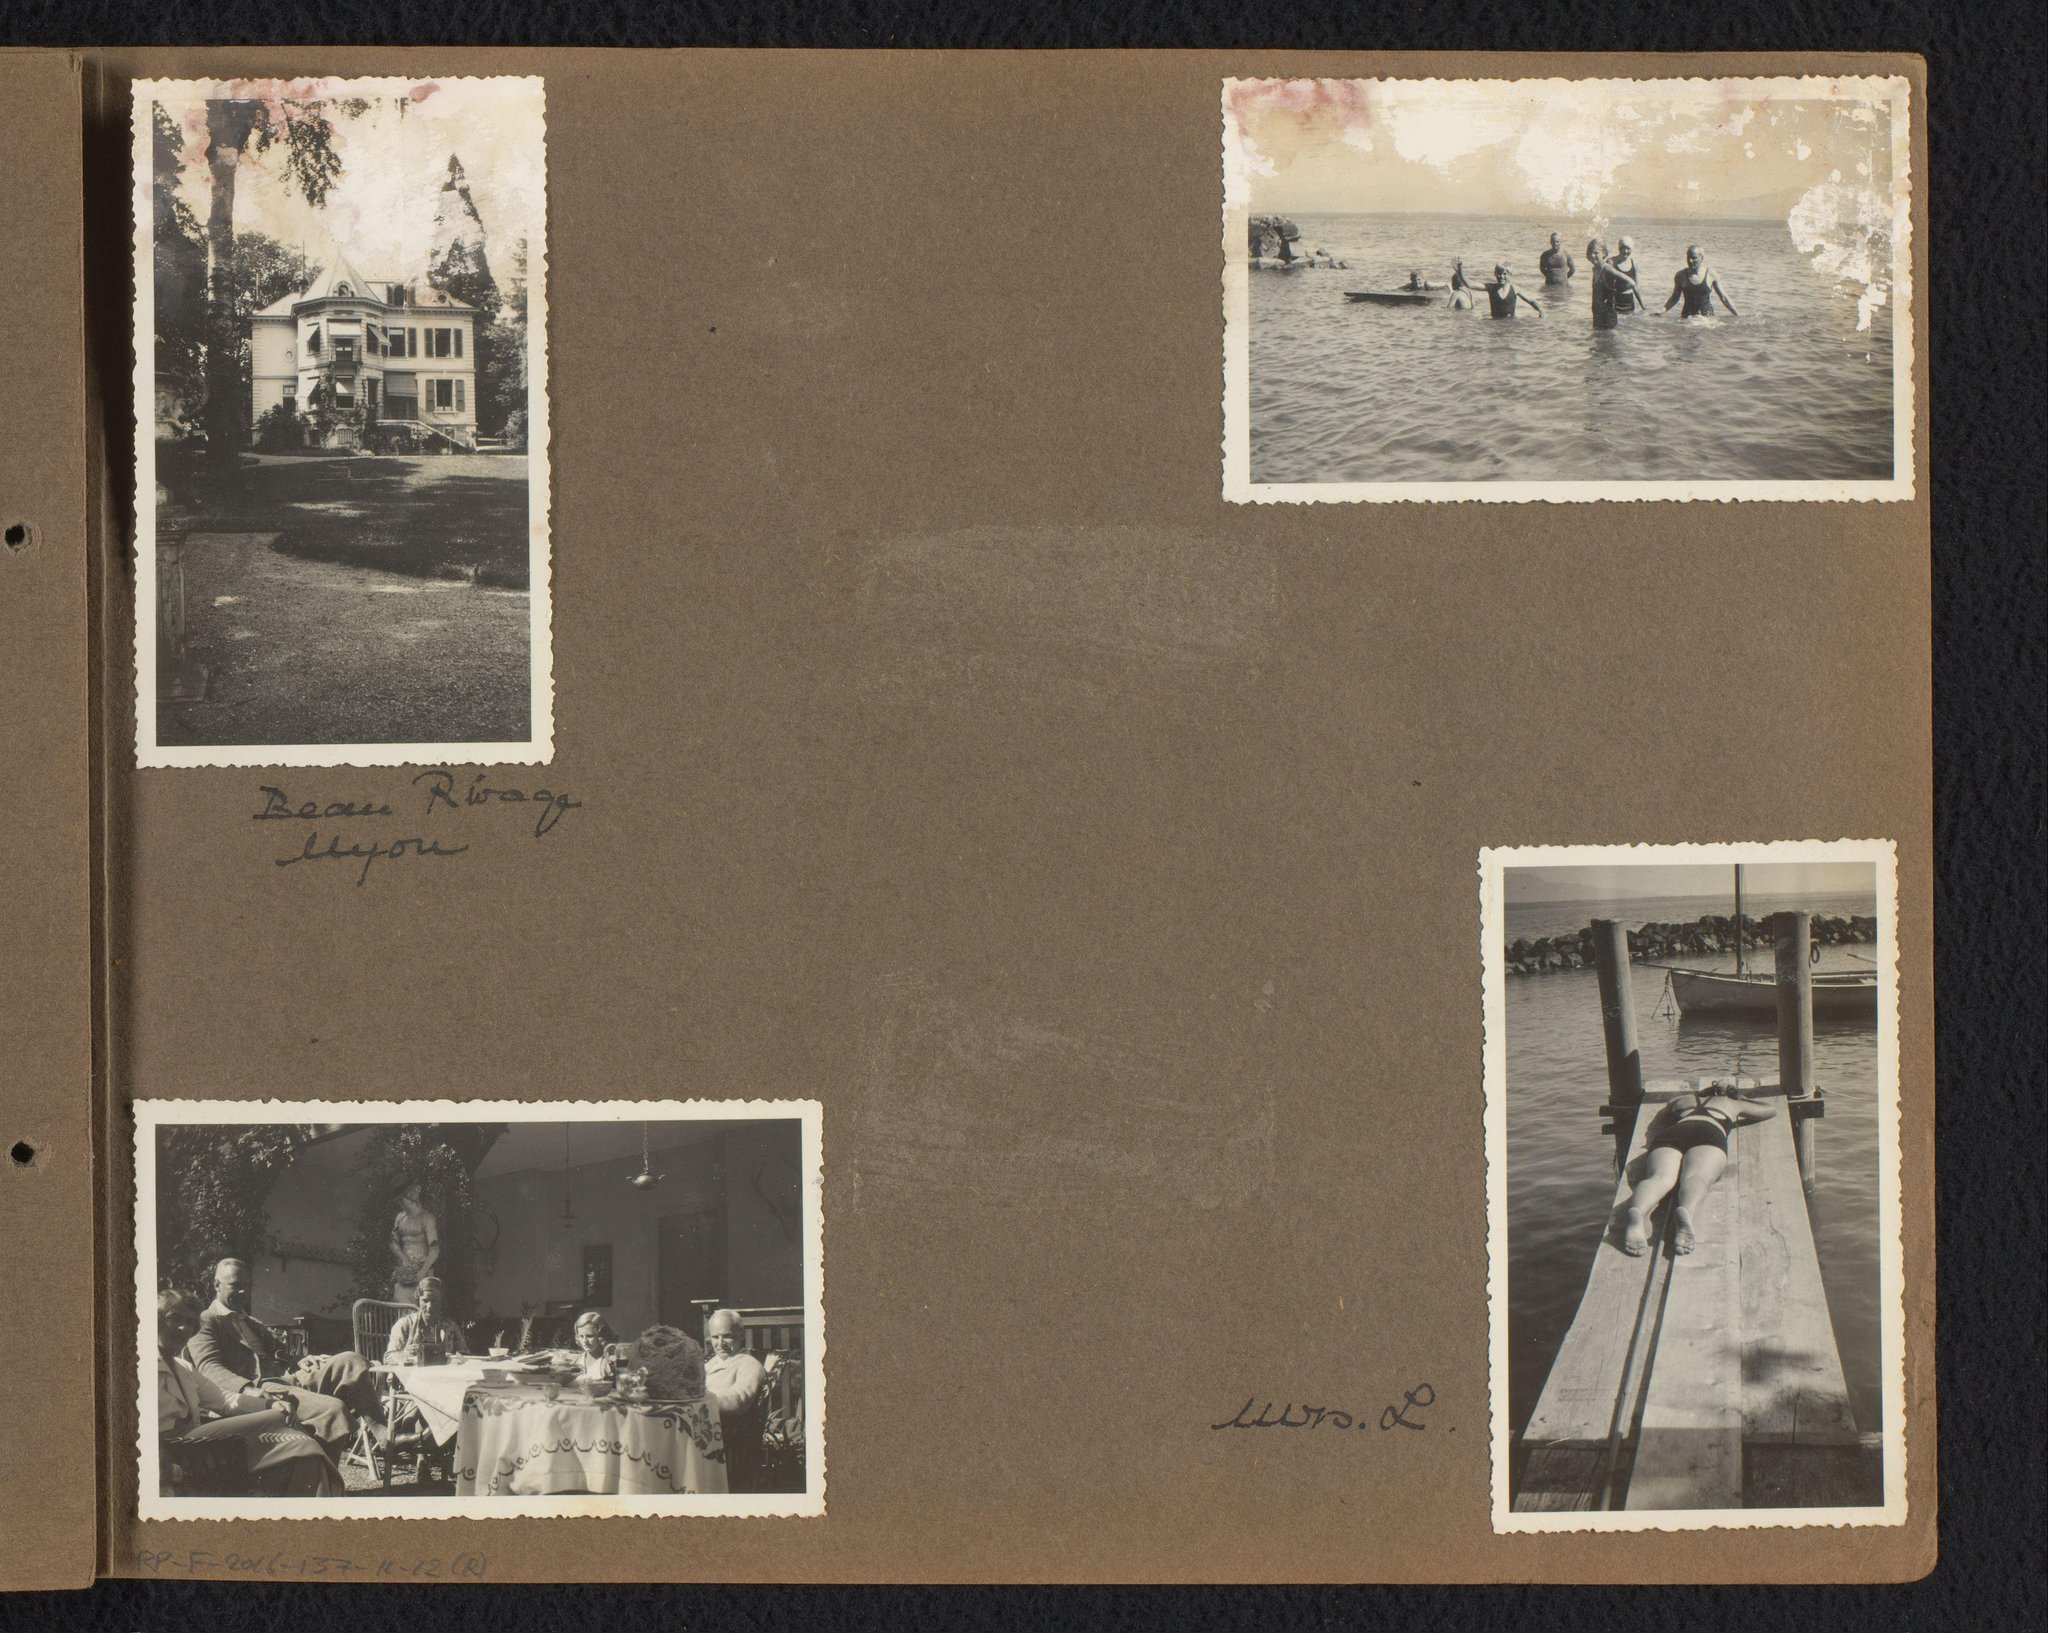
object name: album leaf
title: Gezin Furnée bij Lyon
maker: carolina frederika onnen (lien/loen)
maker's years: 1896-1983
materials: paper, cardboard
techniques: gelatin silver print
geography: lyon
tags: family life, lyon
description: Deze foto's zijn onderdeel van een album.